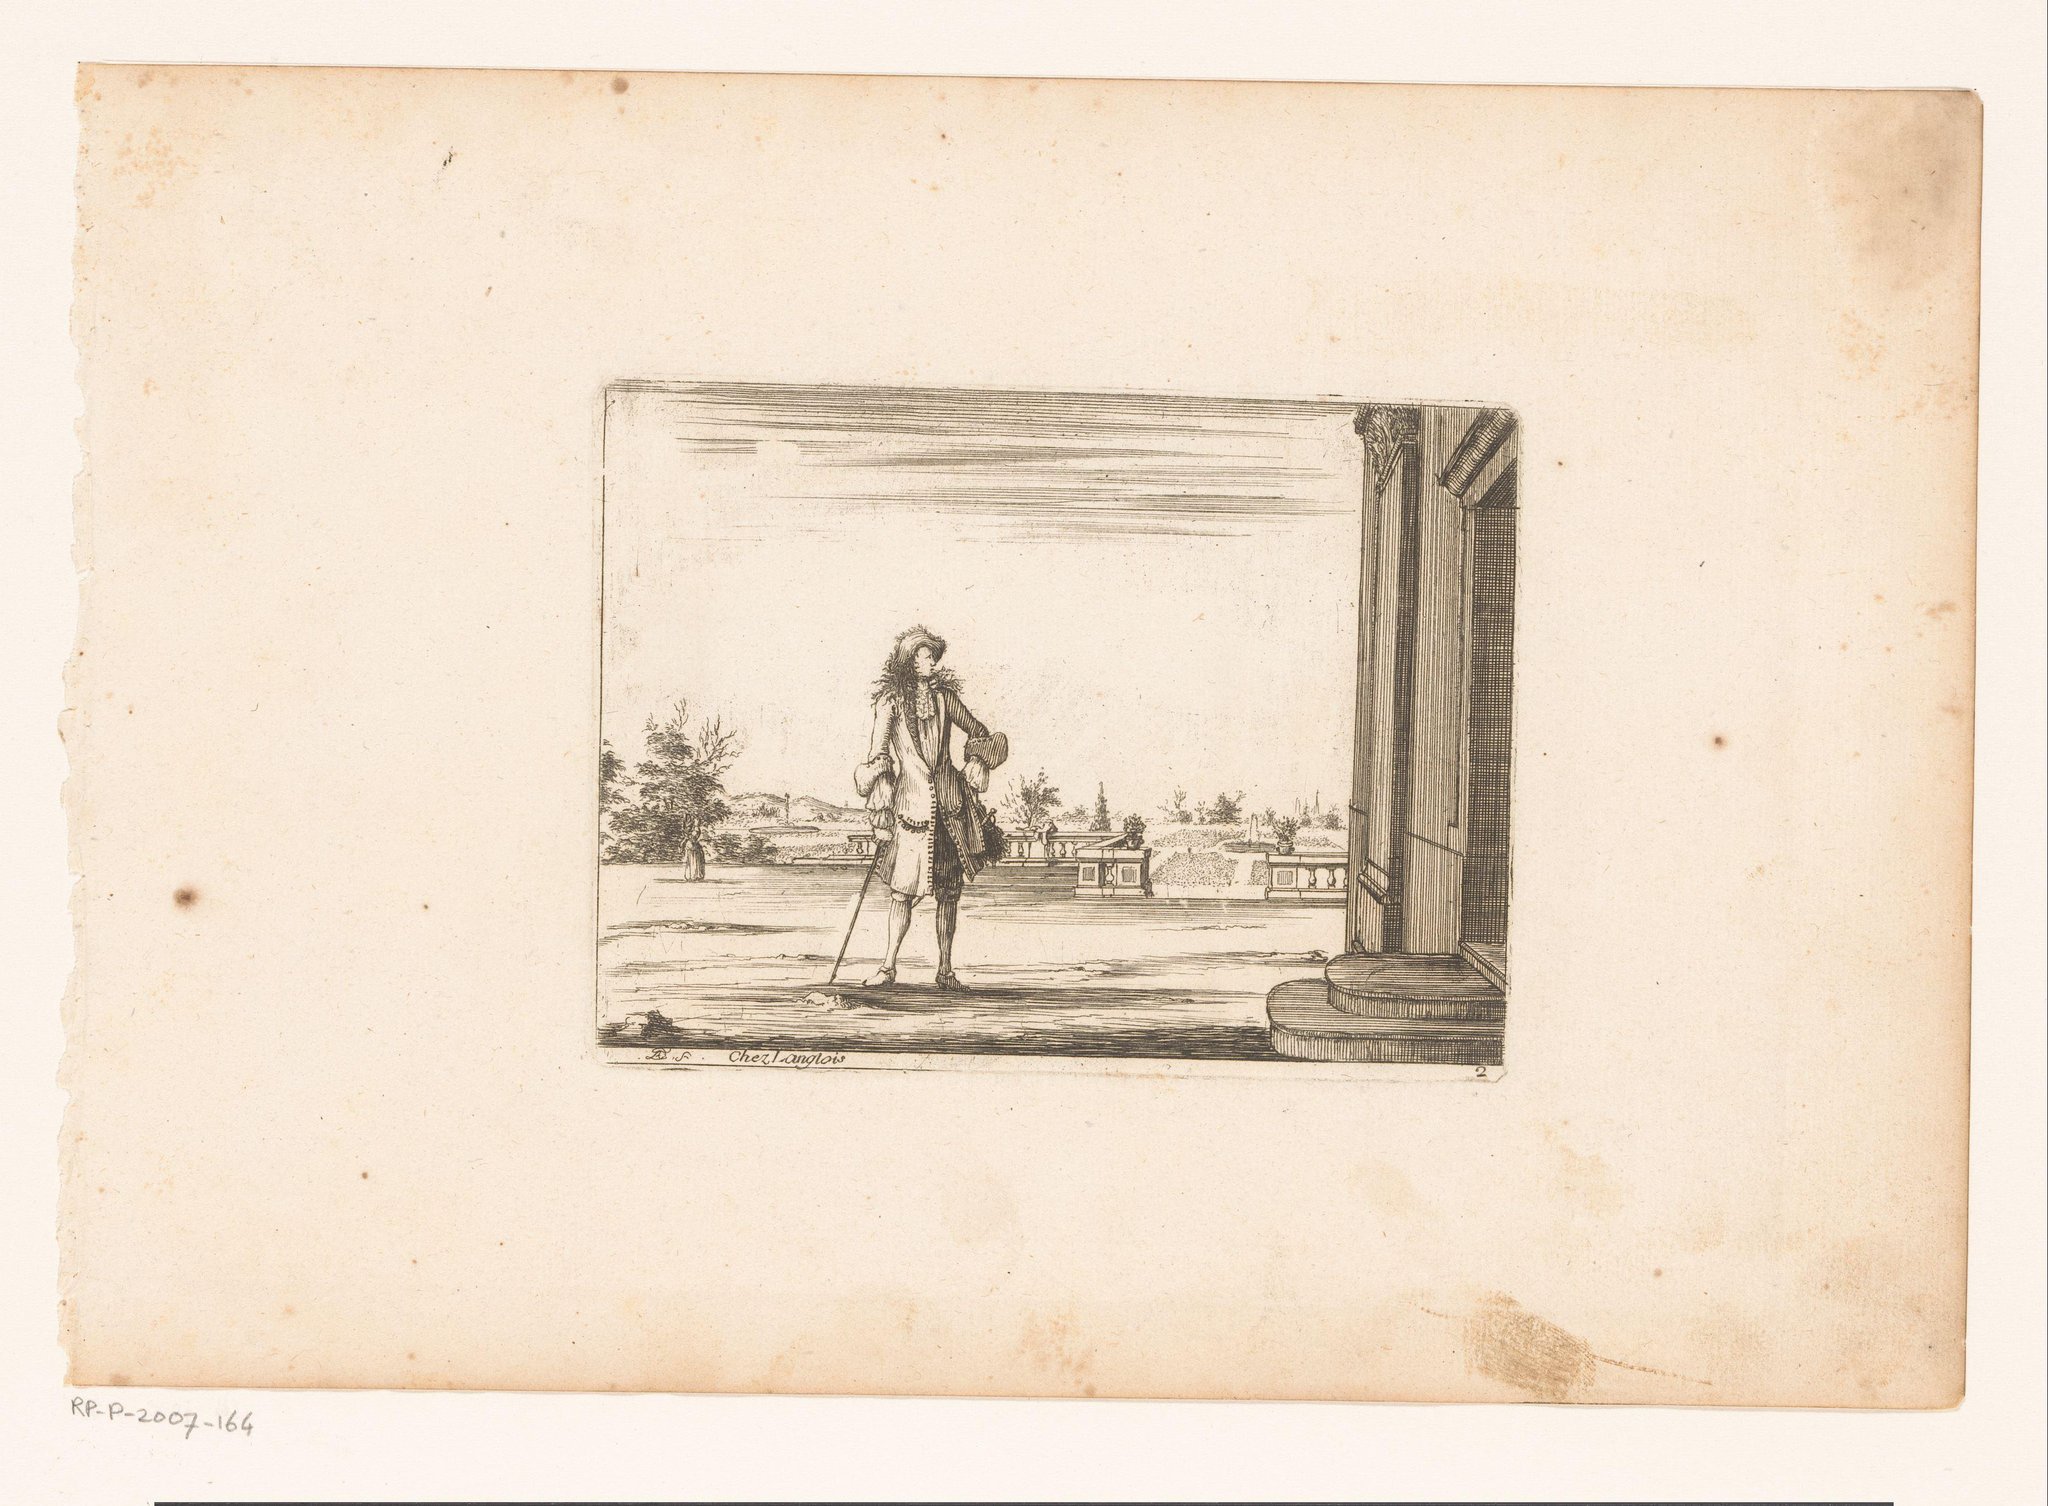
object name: print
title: Diverses figures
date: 1670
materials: paper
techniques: etching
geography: paris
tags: garden, adult man, clothes, costume (+ men's clothes)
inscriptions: collector's mark: Lugt 2760, collector's mark: Lugt 2228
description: Maakt deel uit van een serie van twaalf prenten met verschillende figuren, uitgegeven door Langlois in Parijs.